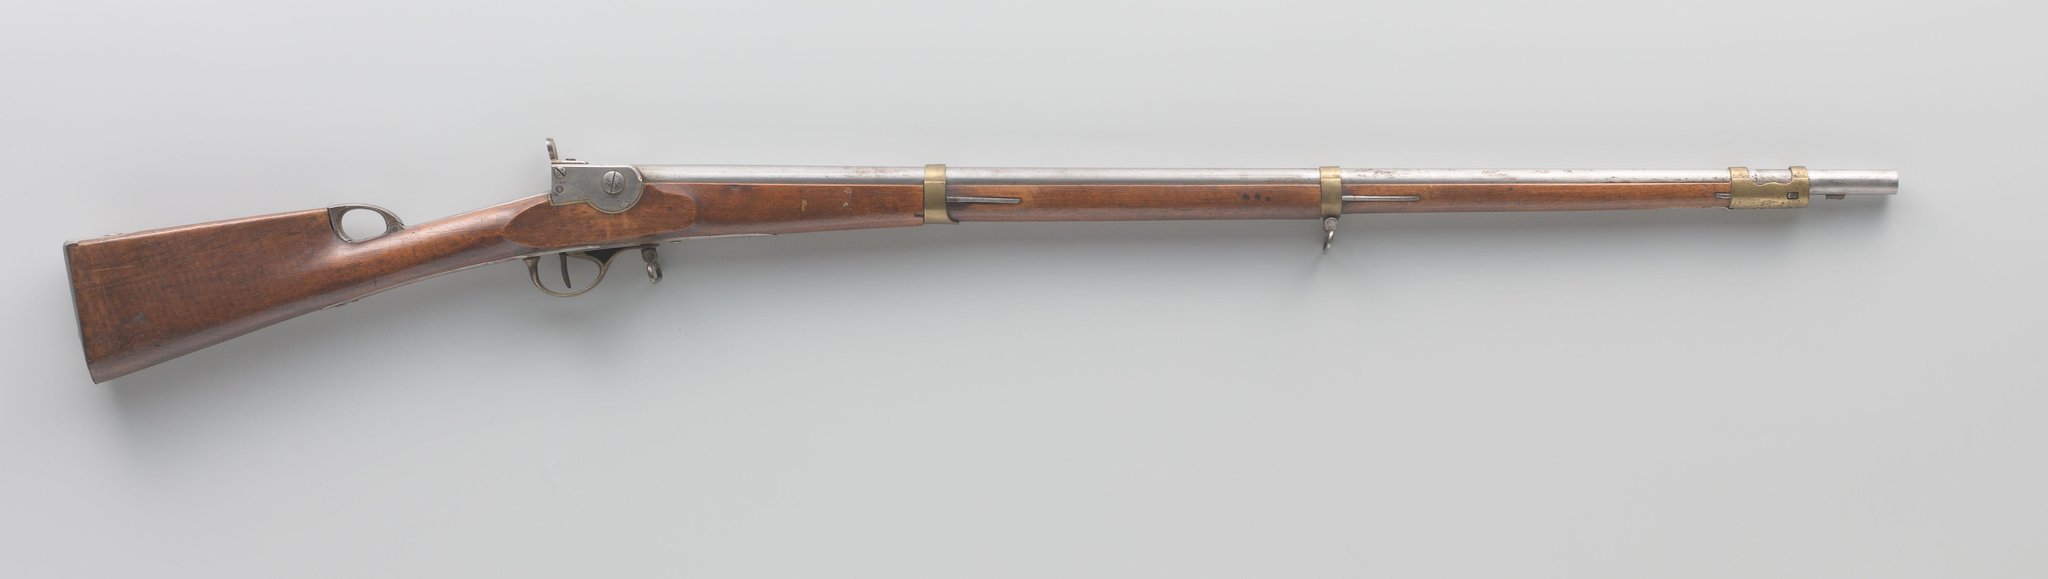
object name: rifle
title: Breech-Loading Gun, Robert System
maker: joseph alexandre robert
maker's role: geweermaker, pistoolmaker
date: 1832-1835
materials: brass, iron, leather, wood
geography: paris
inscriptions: inscription, on the bayonet: ‘FUSIL ROBERT / BREVETE / PARIS.N.62 L / 28 / K’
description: Robert's achterlader was geïnspireerd op de achterladers van Johann Samuel Pauly en diens navolgers Eugen Pichereau en Generaal Remond. Het geweer gebruikte papieren patronen met een kort ontstekingsbuisje. Roberts tweede gepatenteerde achterlaadgeweer (Robert II 1832), waarvan dit een exemplaar is, vond bij het Franse leger een, zij het geringe, toepassing als walbus.